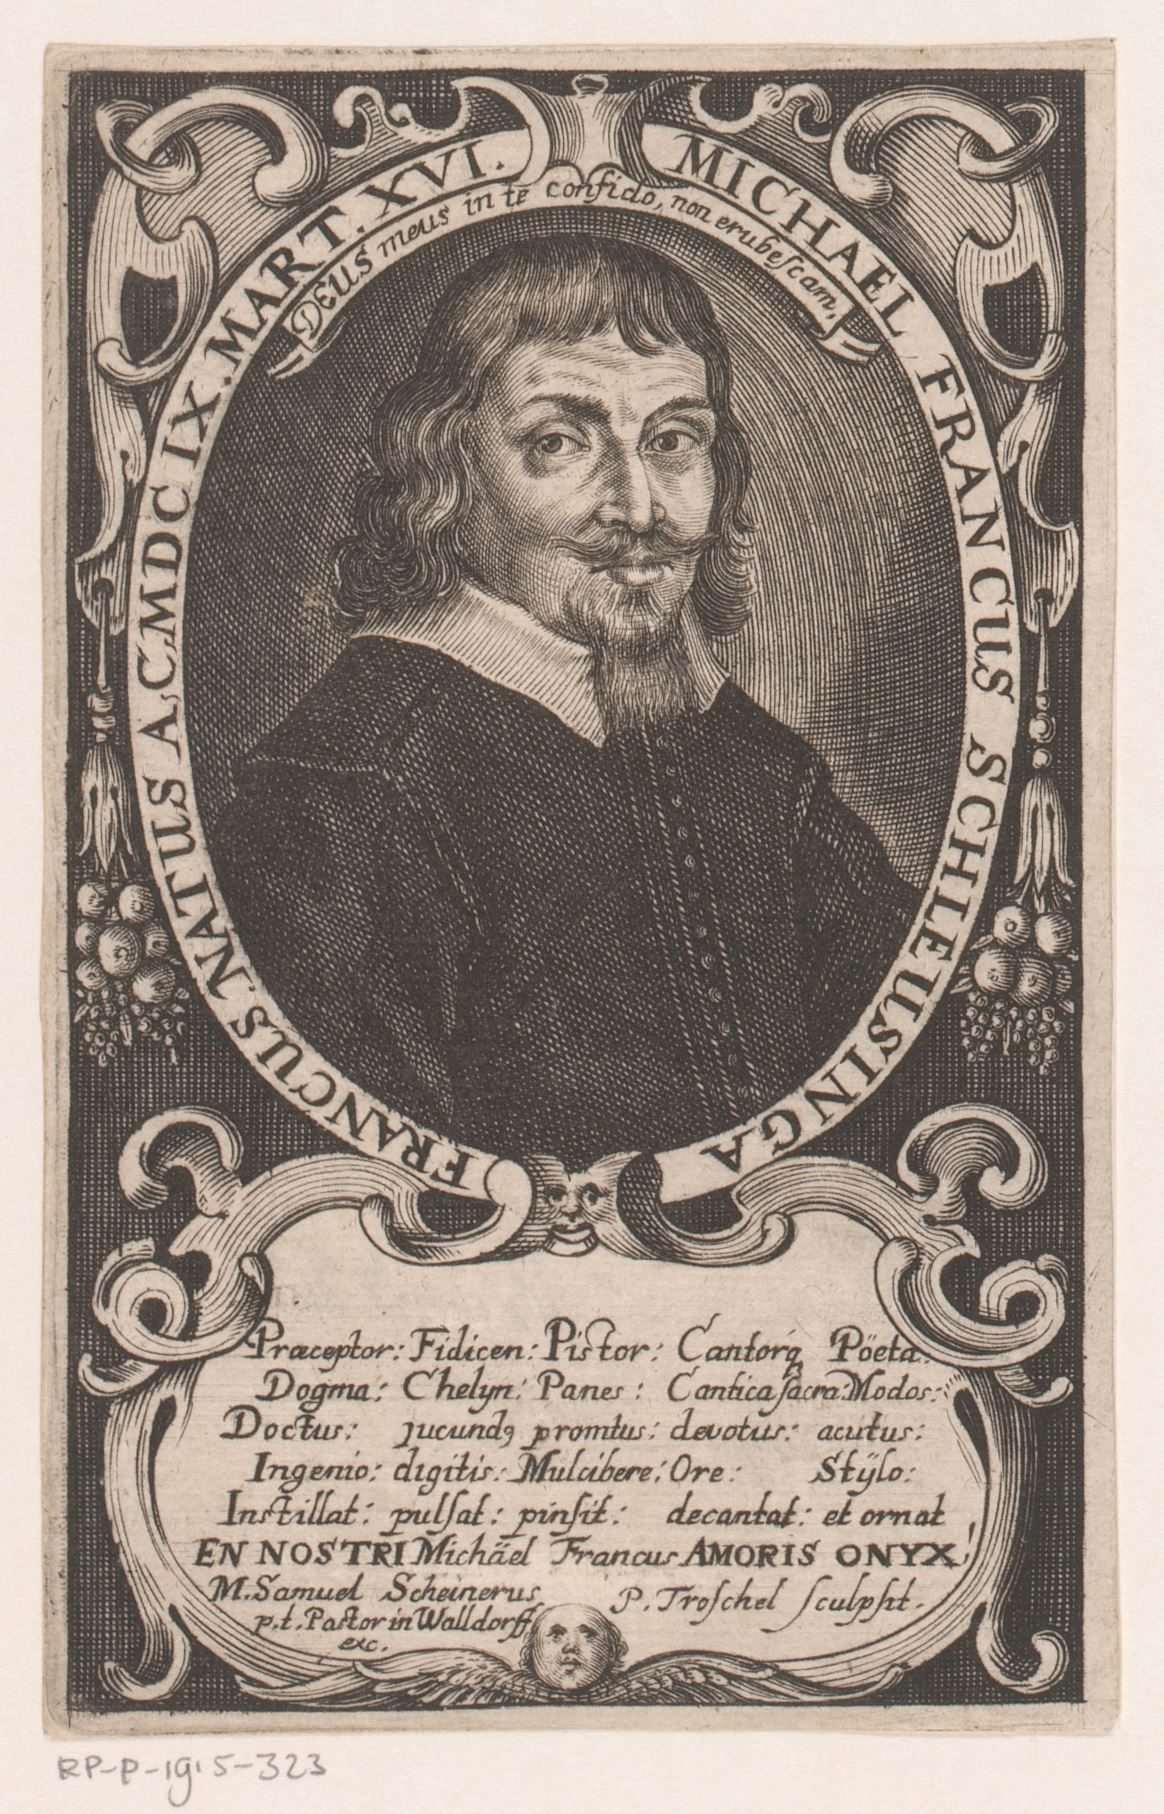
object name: print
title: Portret van Michael Franck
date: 1640-1670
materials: paper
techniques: engraving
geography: germany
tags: michael franck, historical persons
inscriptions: collector's mark: Lugt 2228